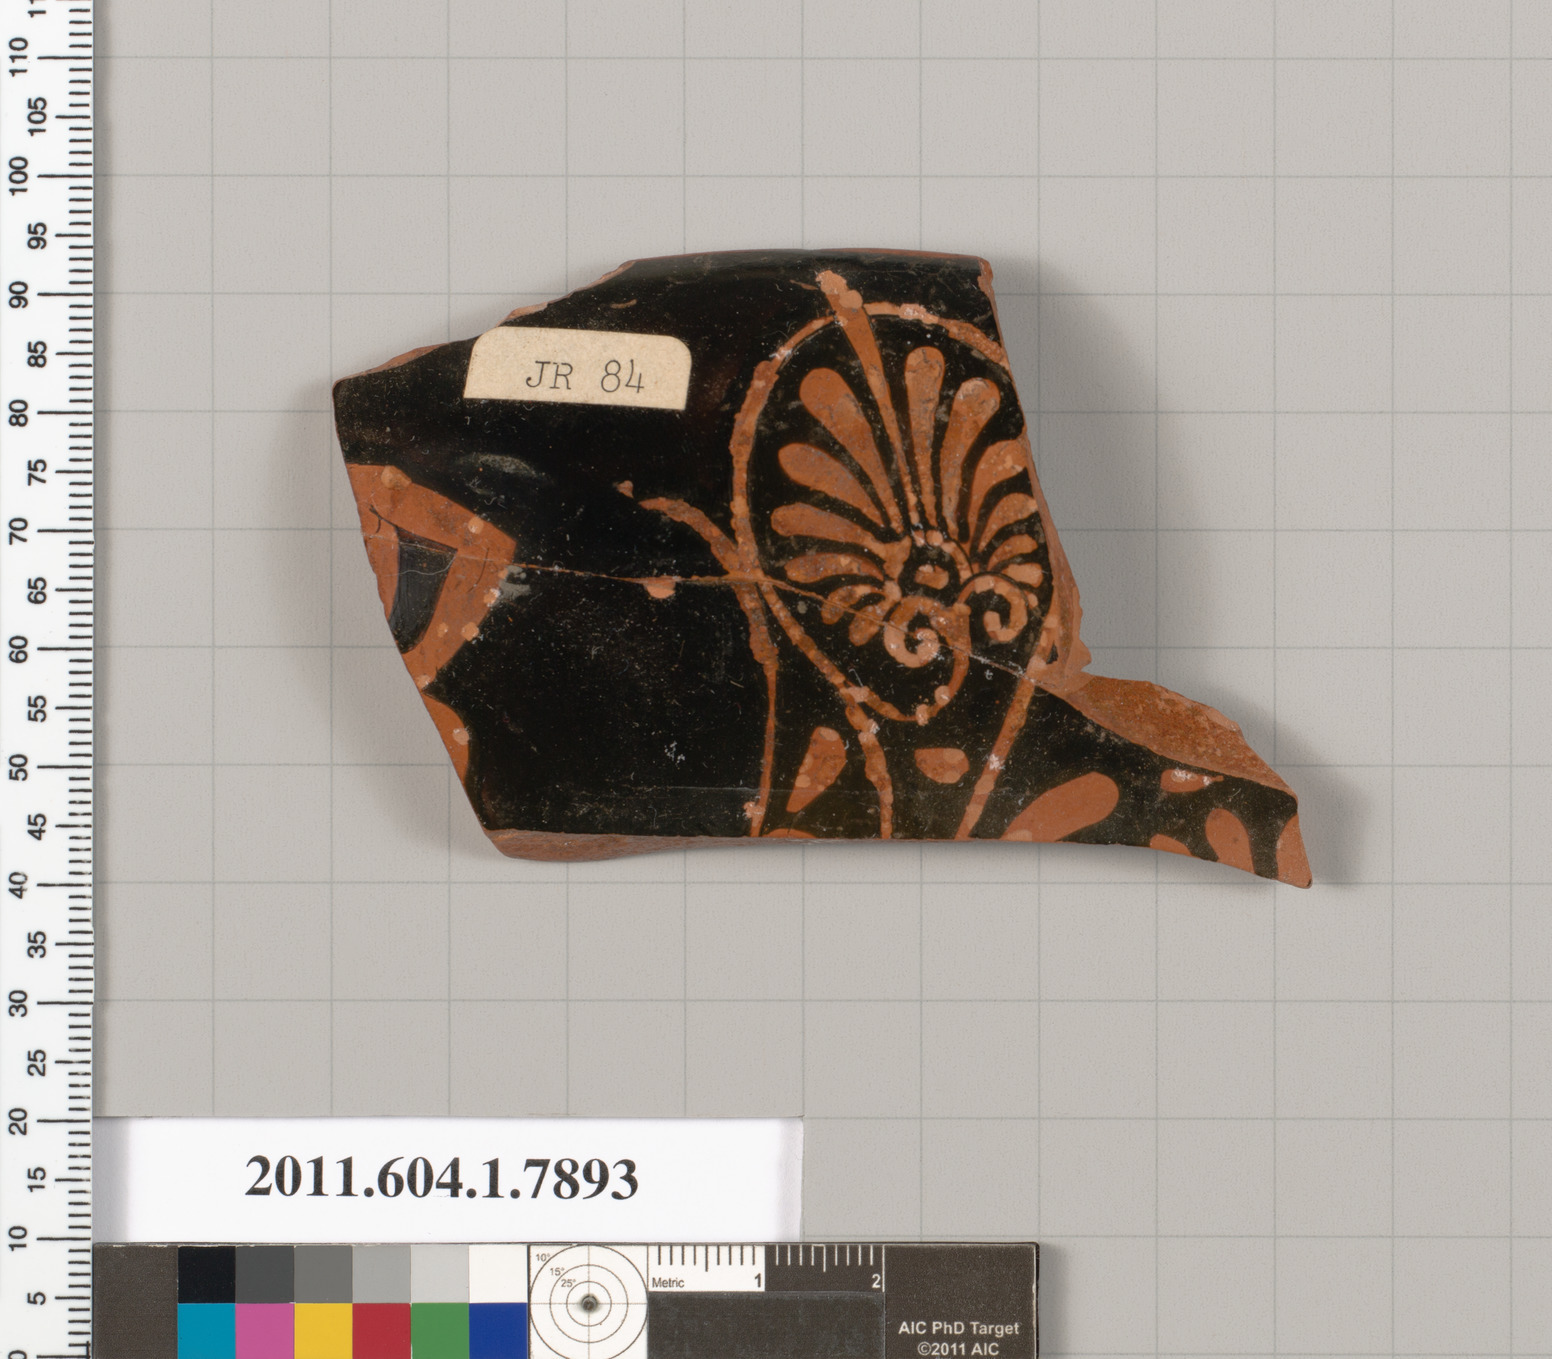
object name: kylix fragment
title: Terracotta rim fragment of a kylix (drinking cup)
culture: greek, attic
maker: painter of london e 777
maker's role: artist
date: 450 BCE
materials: terracotta